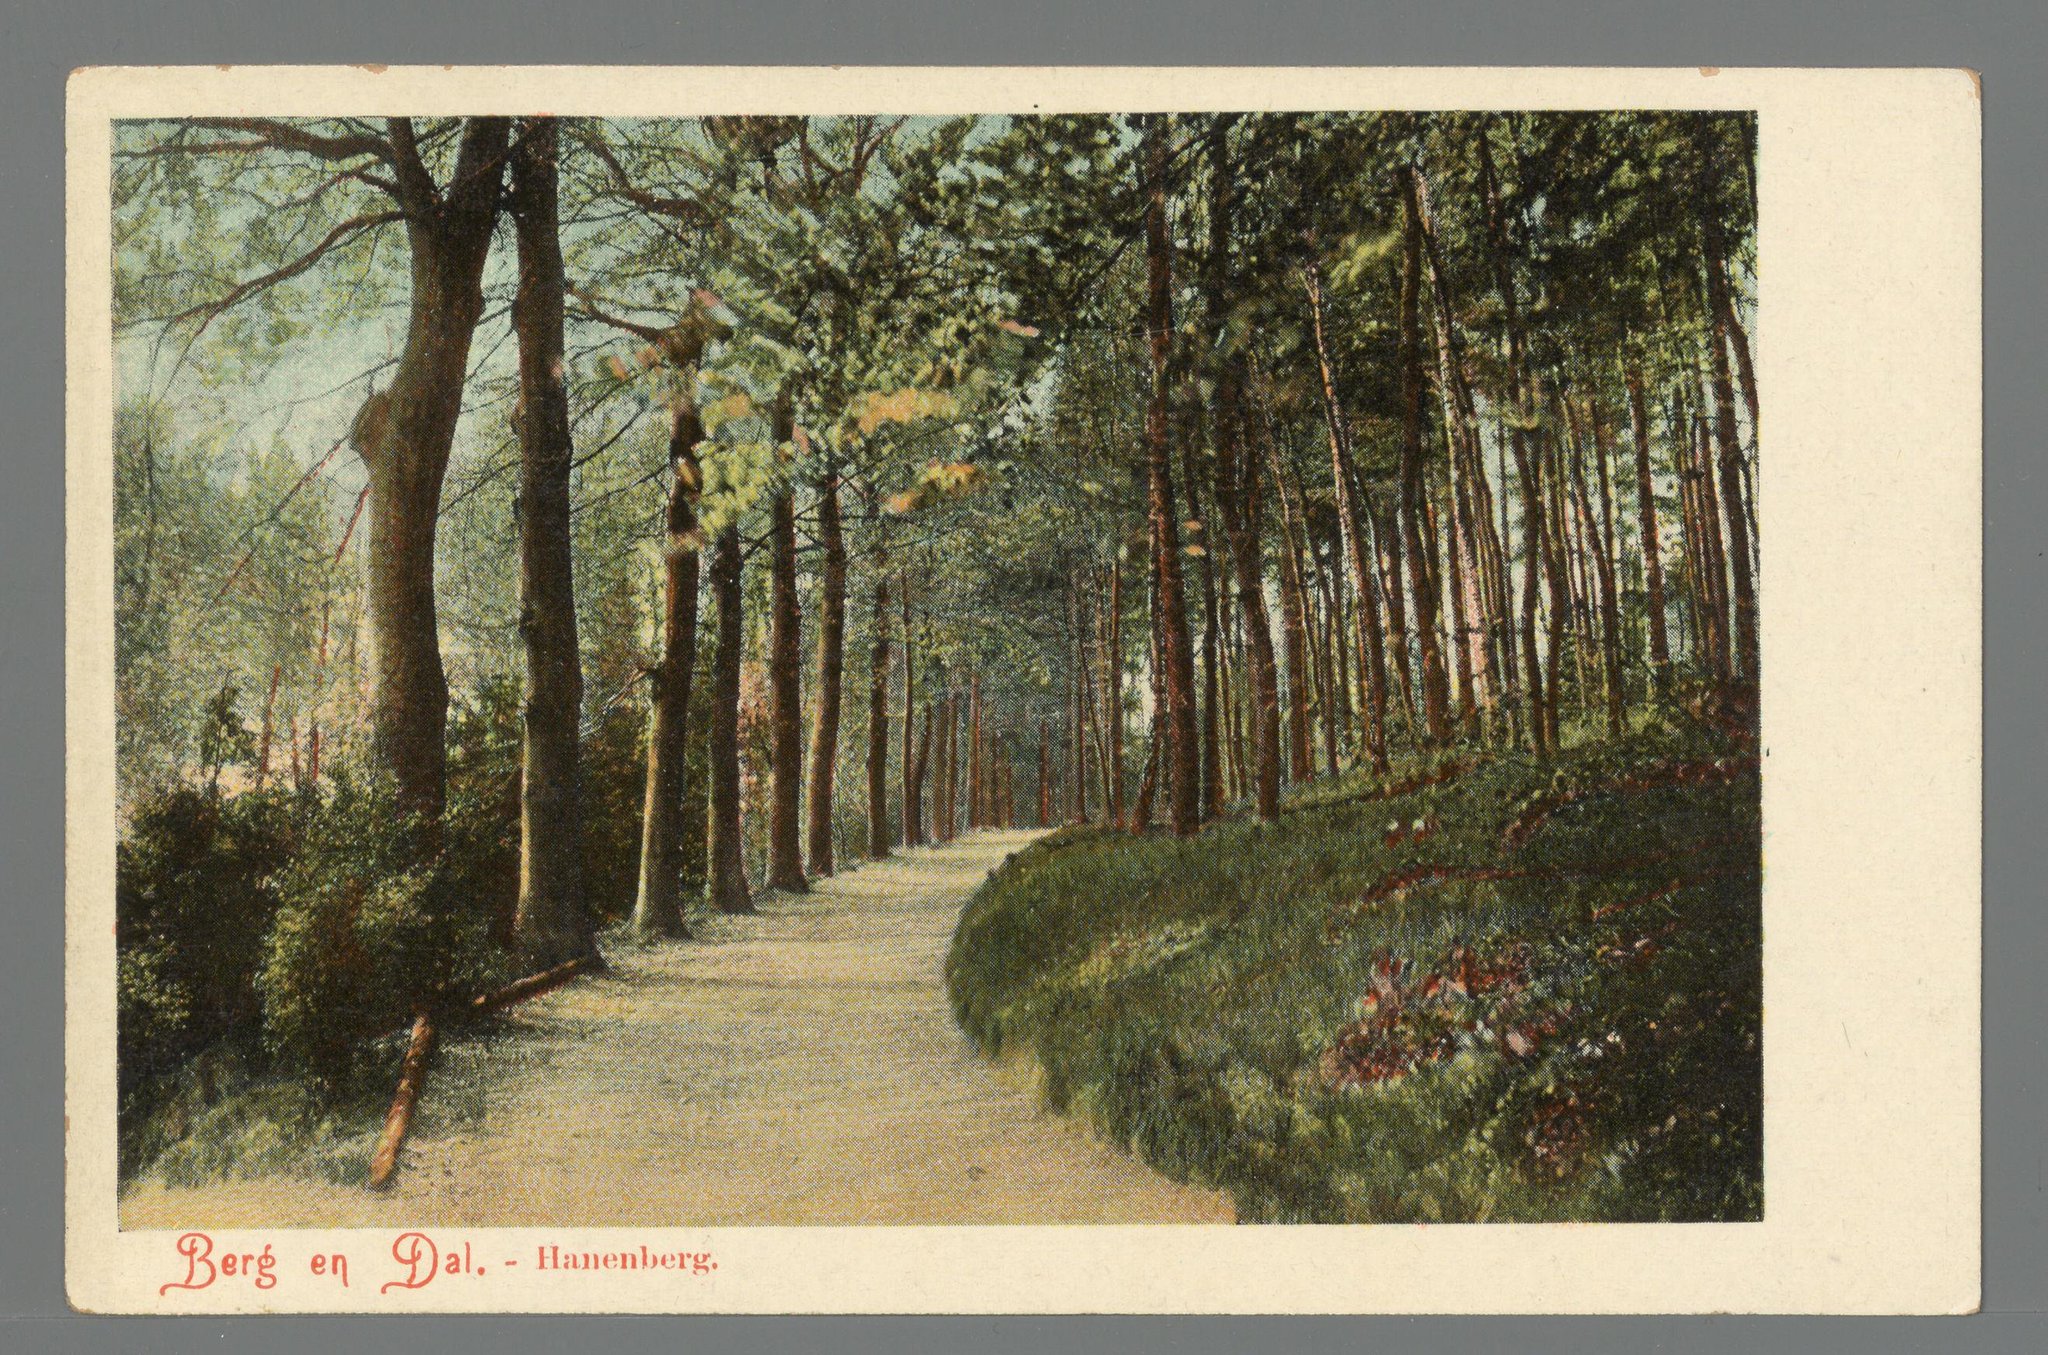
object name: photomechanical print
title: Berg en Dal. - Hanenberg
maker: Anonymous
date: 1905-1930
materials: cardboard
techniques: lithograph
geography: berg en dal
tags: forest path or lane, mountains